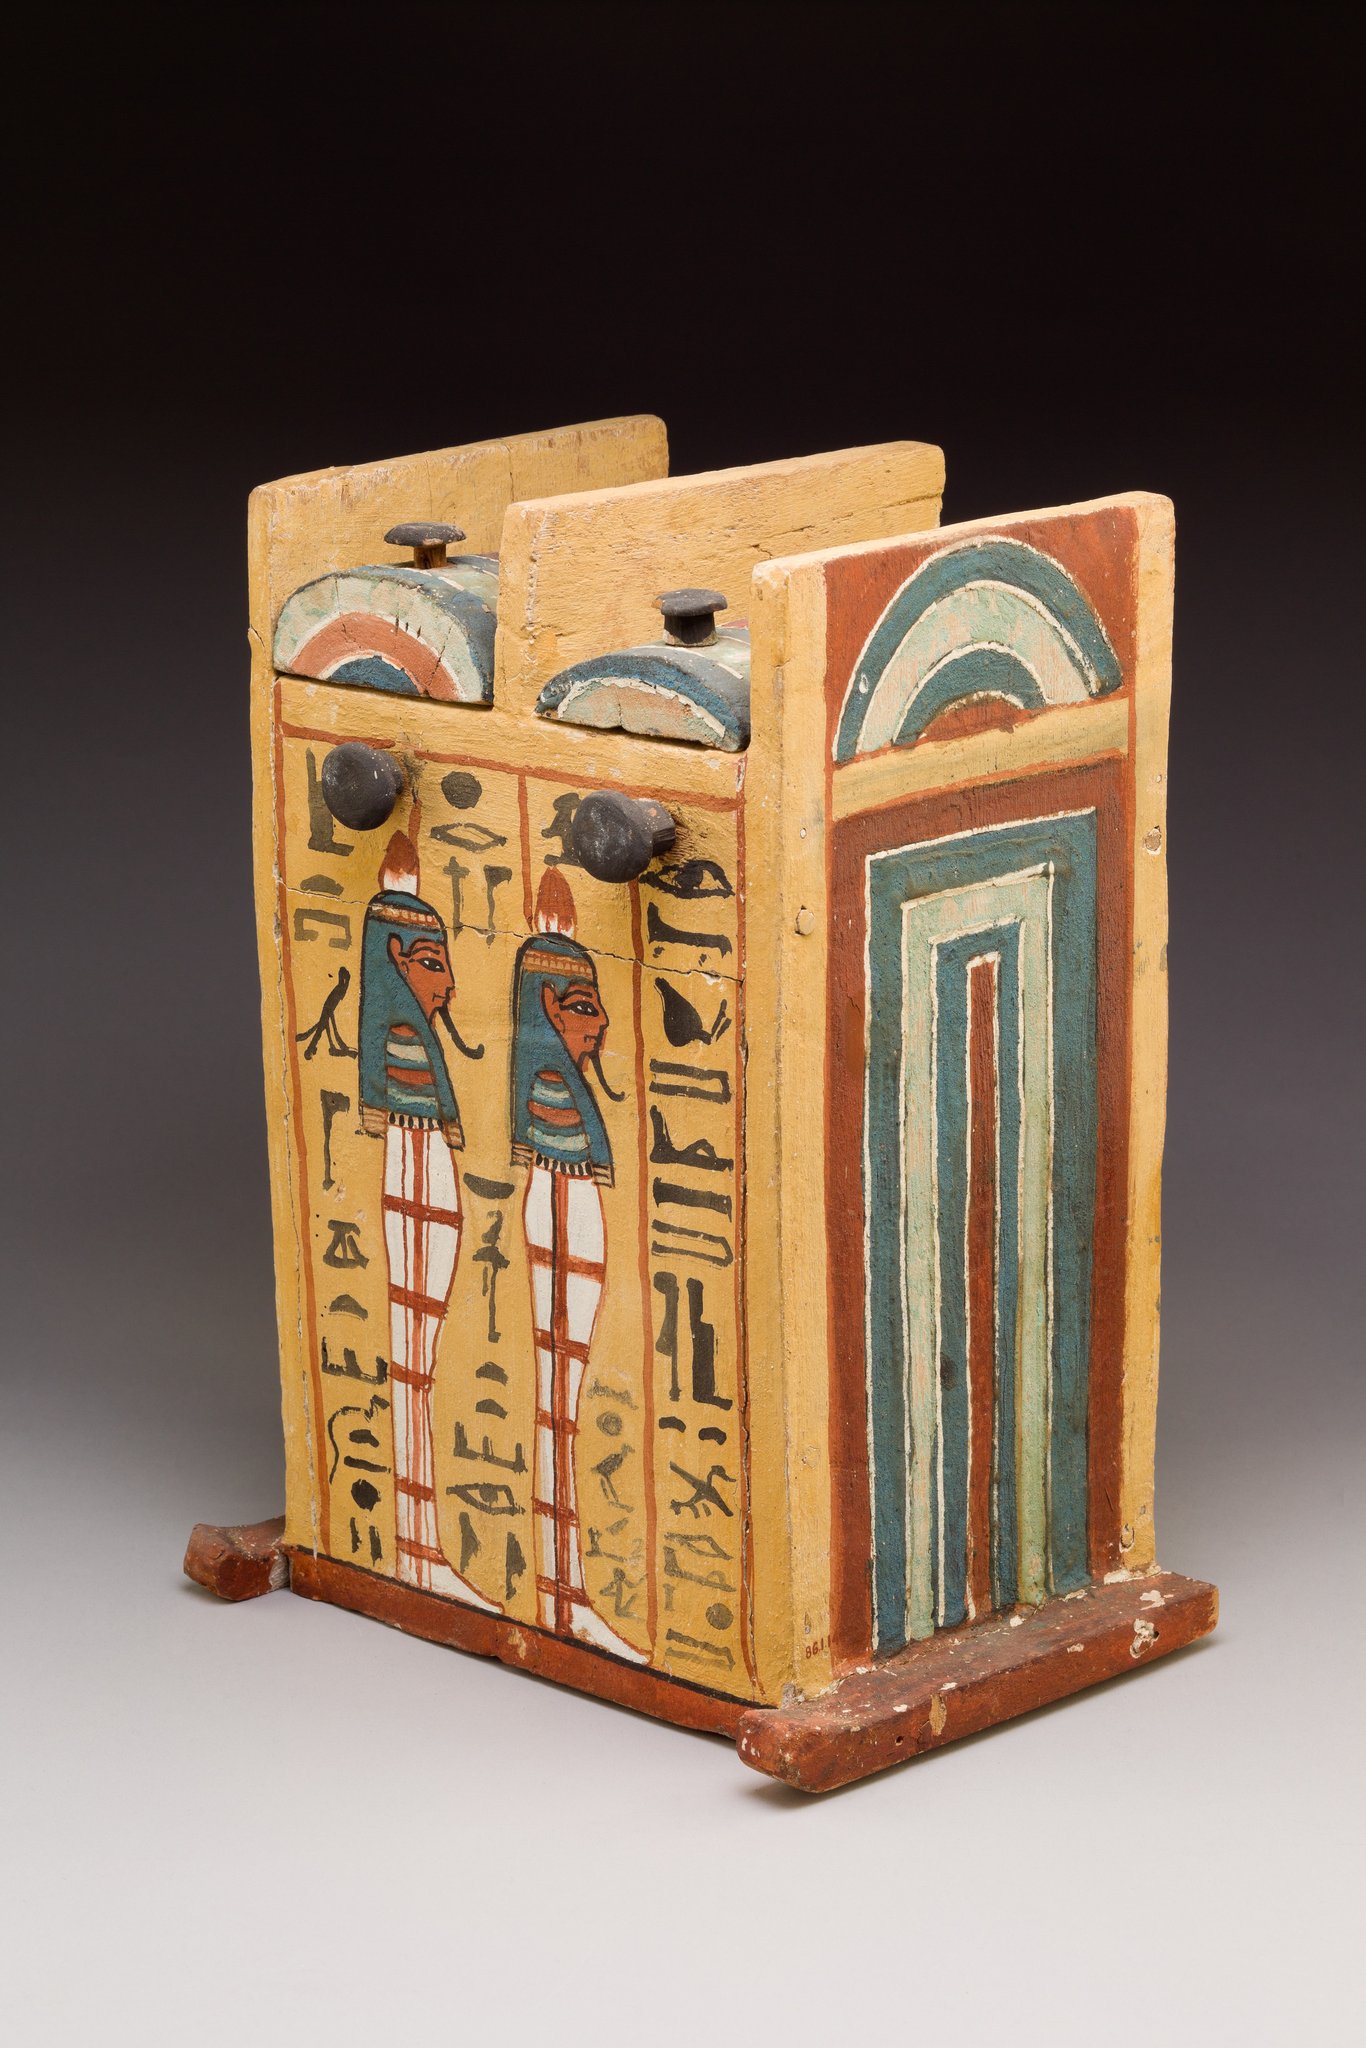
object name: shabti box, paramnekhu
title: Shabti box of Paramnekhu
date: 1279-1213 BCE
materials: gesso, paint, wood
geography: egypt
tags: hieroglyphs